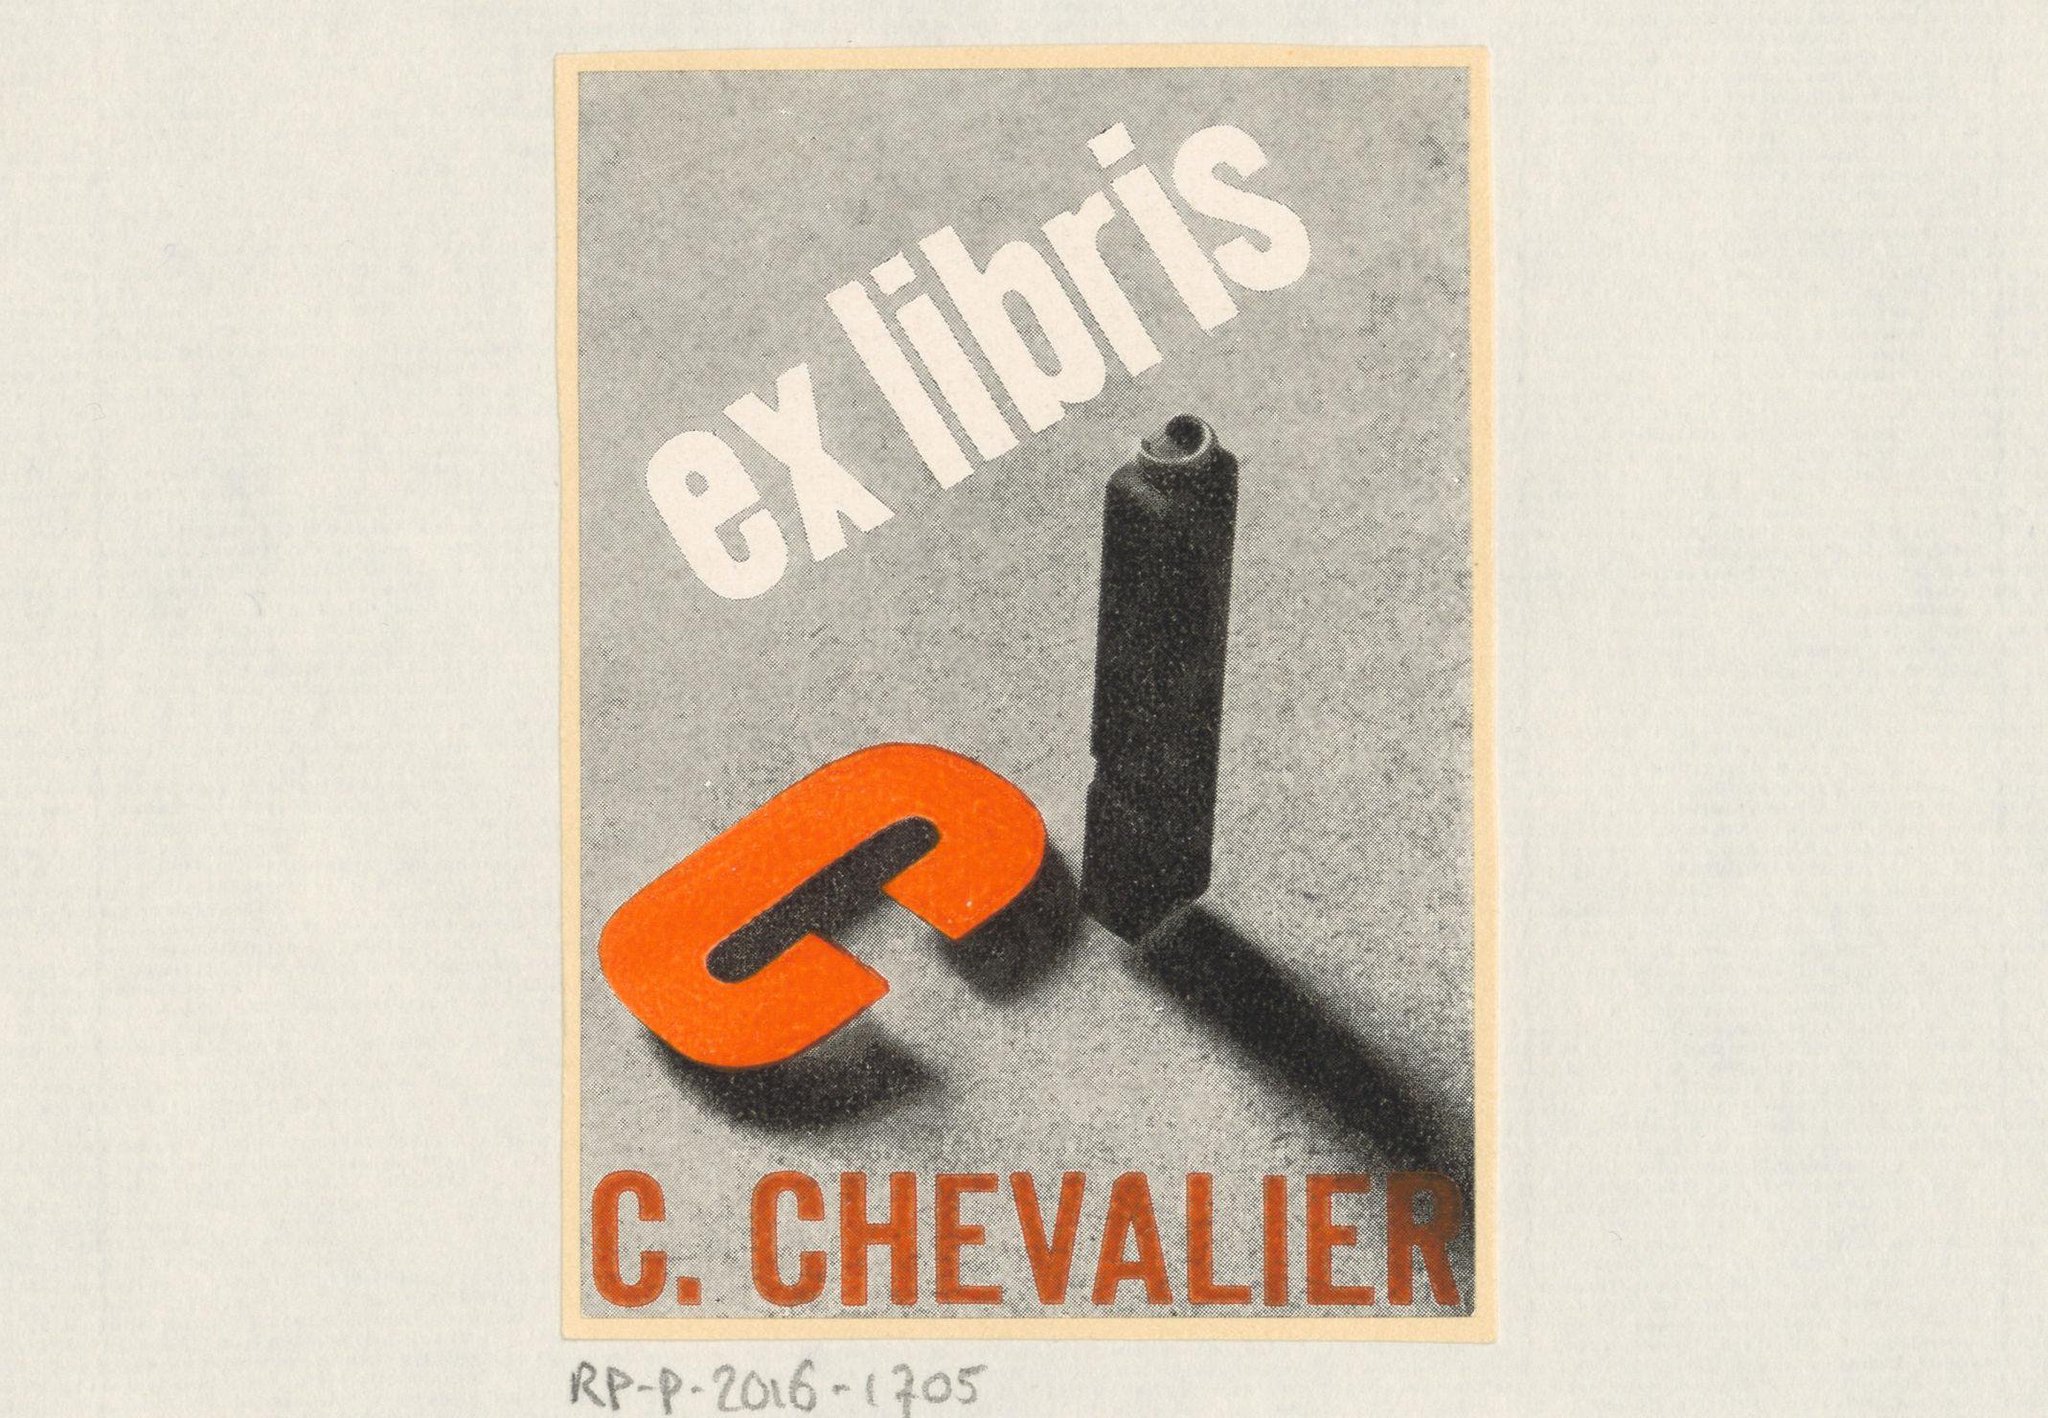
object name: photomechanical print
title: Ex libris van Cees Chevalier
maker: Anonymous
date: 1950-1999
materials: paper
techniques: printing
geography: rotterdam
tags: cees chevalier, type-setter